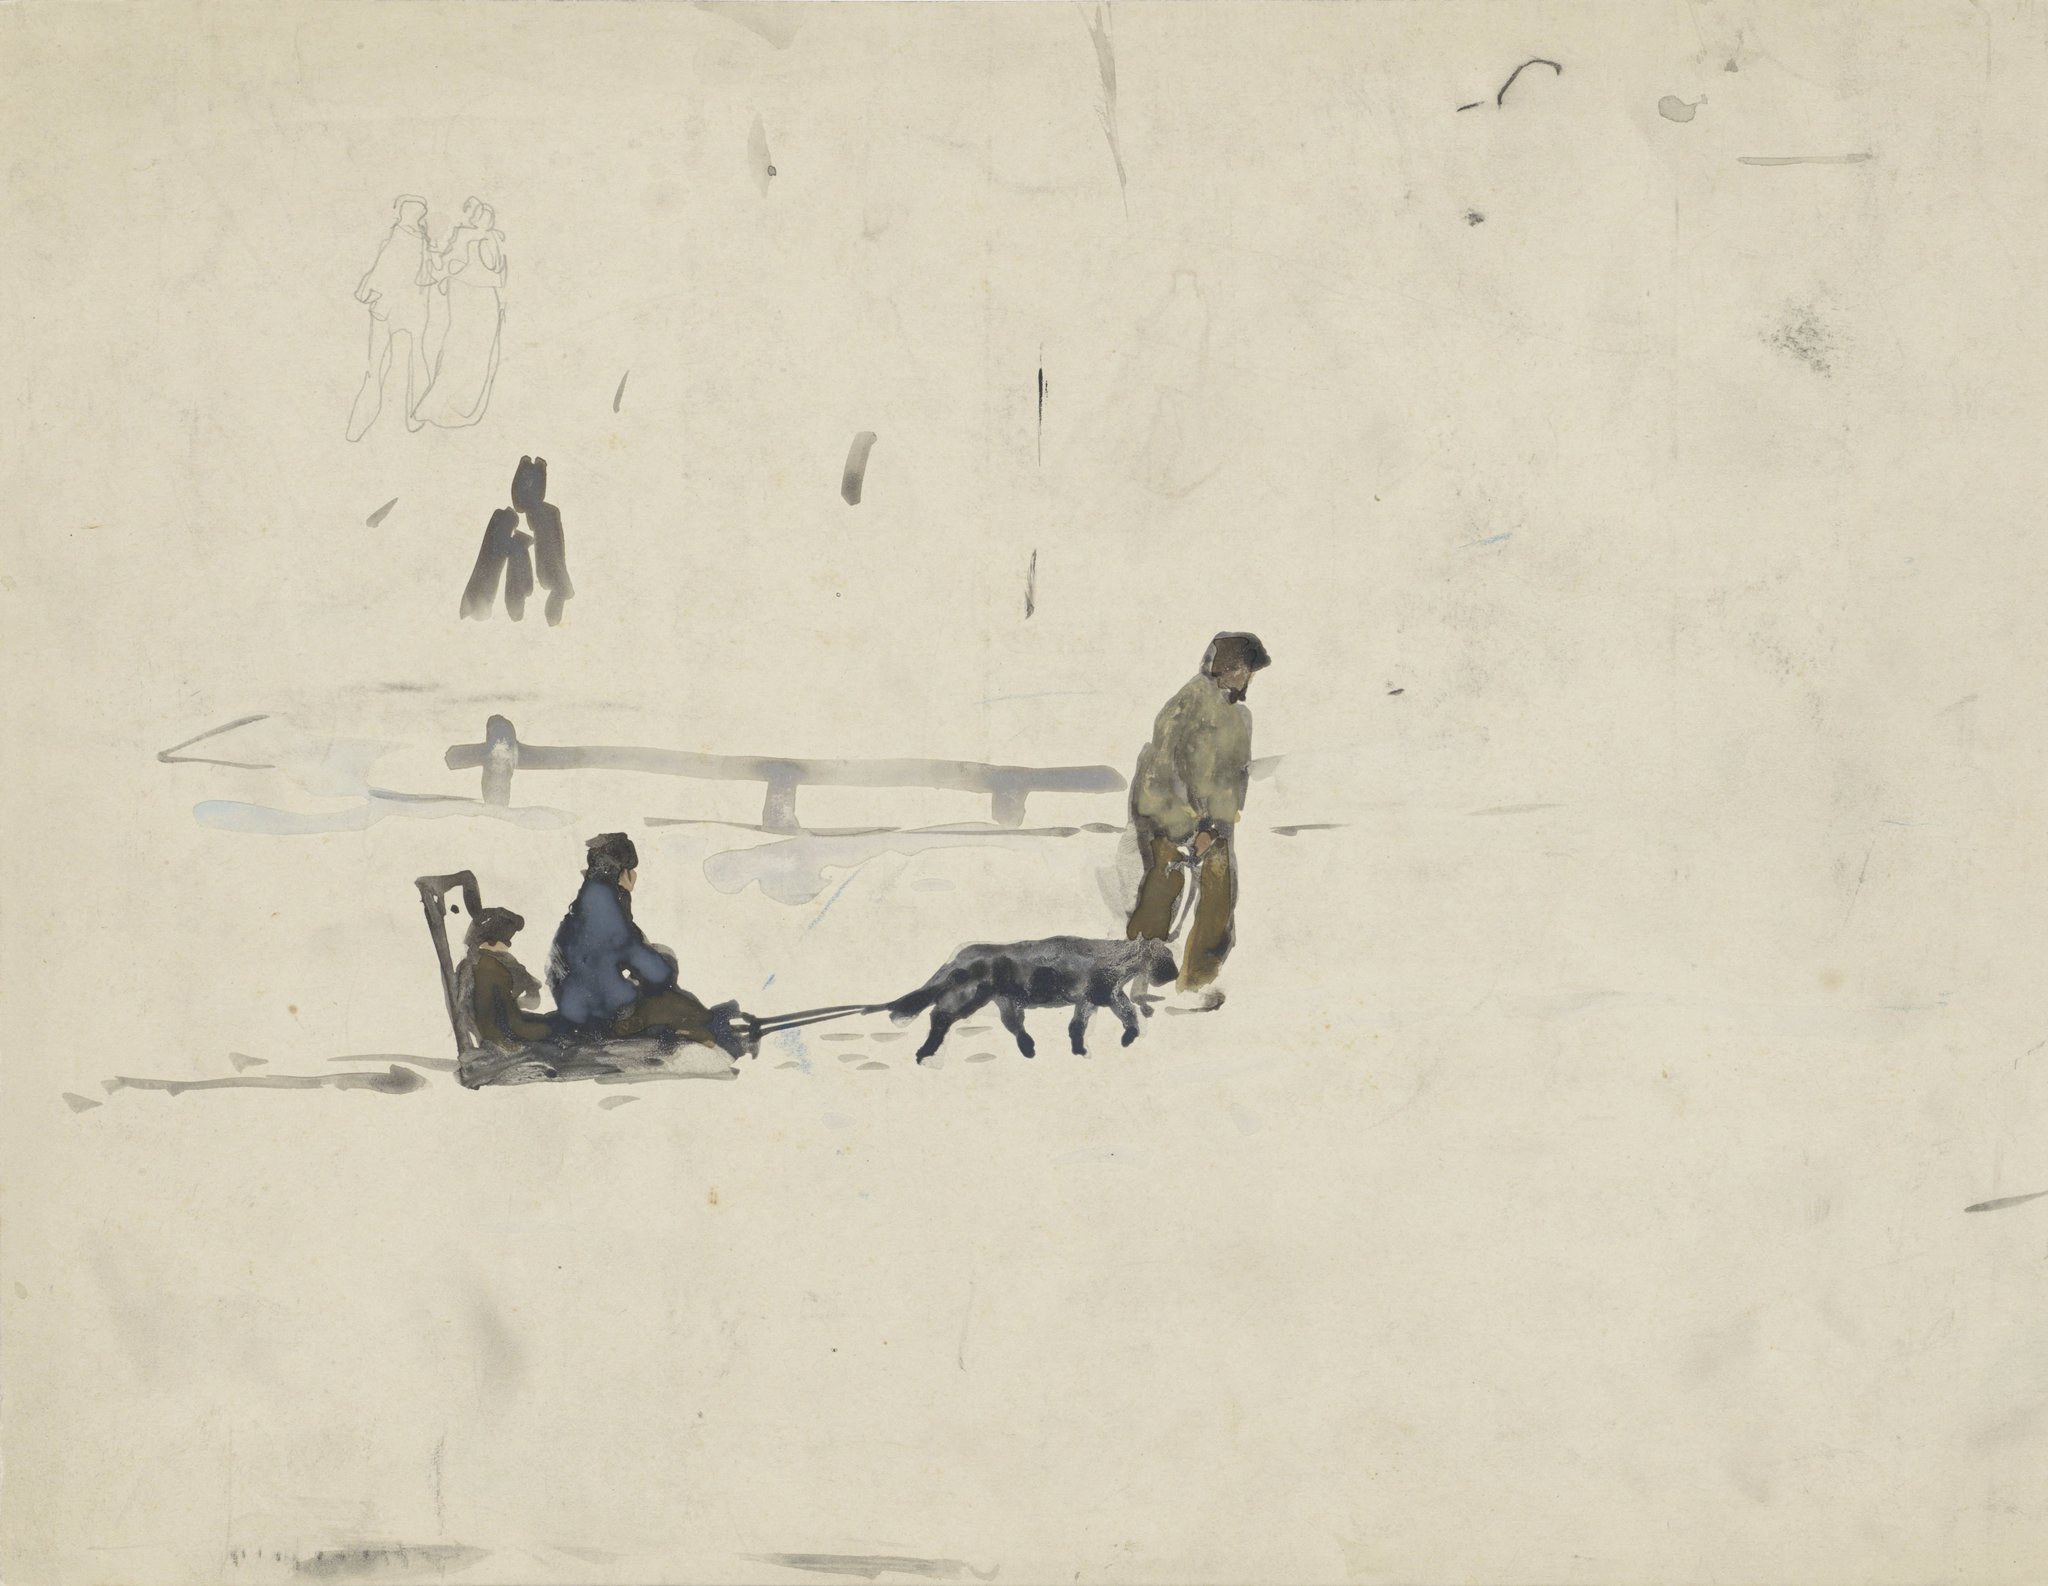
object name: drawing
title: Slede met twee kinderen getrokken door een man met hond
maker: adolf le comte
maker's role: draughtsman, painter, print maker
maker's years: 1850-1921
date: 1860-1921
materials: paper, watercolor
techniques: brush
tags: sliding (playing with snow and ice)